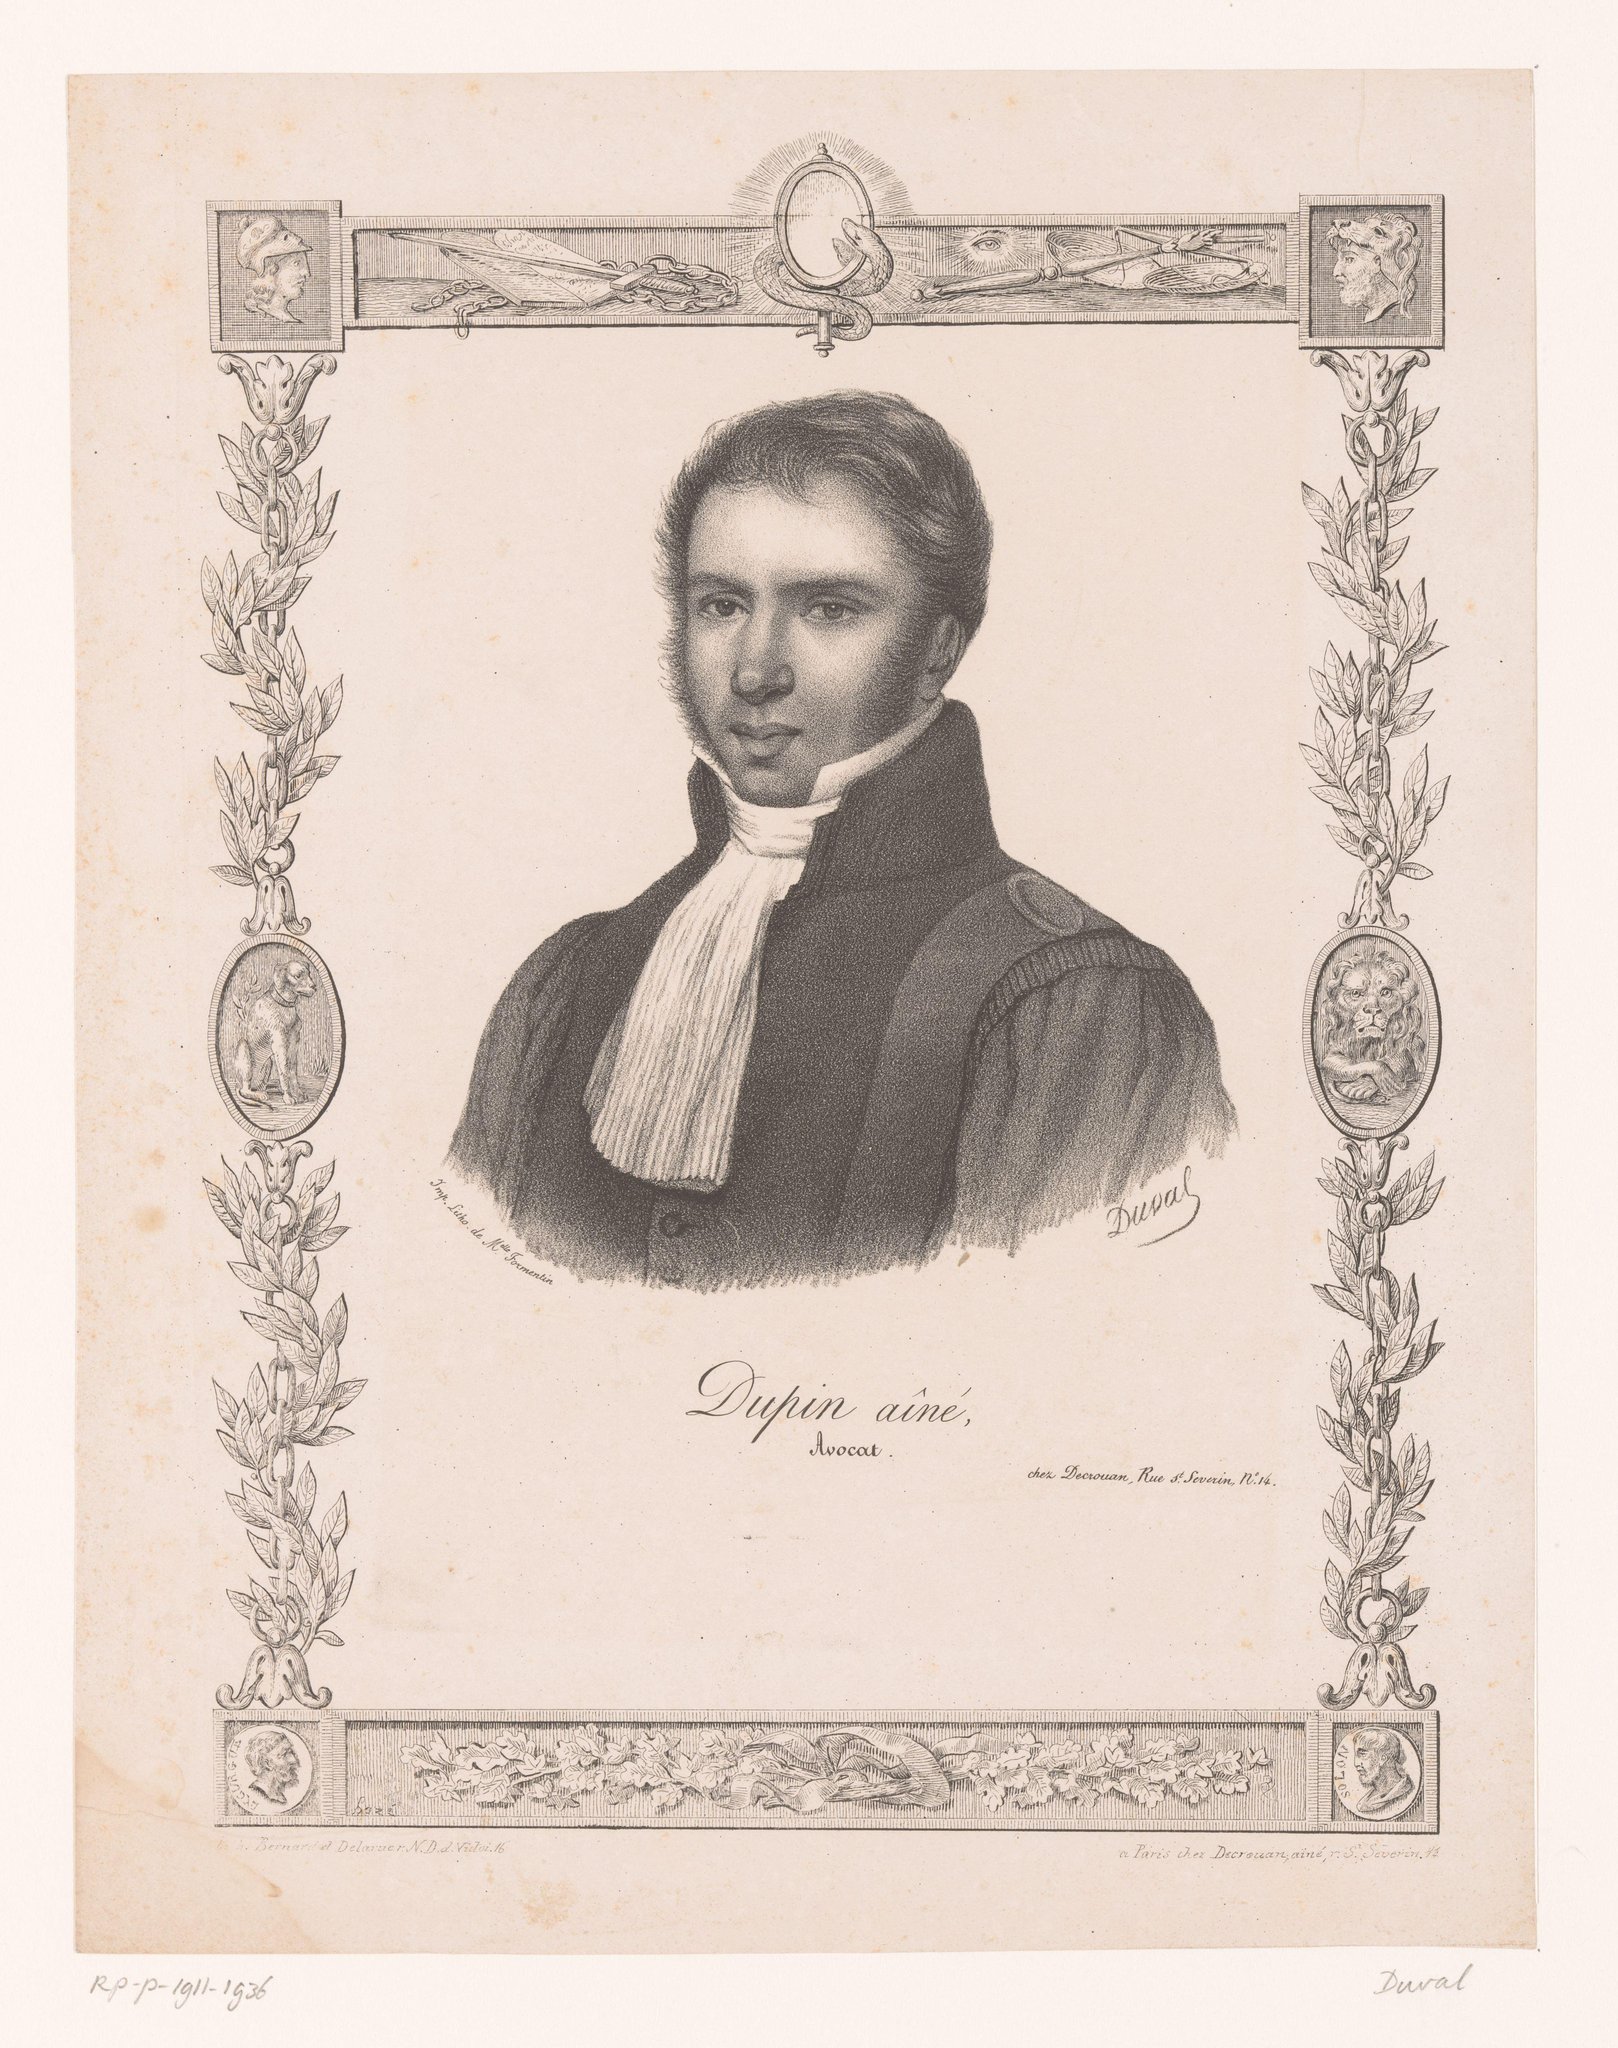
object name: print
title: Dupin aîné, avocat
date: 1826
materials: paper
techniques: lithograph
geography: paris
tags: historical persons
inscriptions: collector's mark: Lugt 2228a